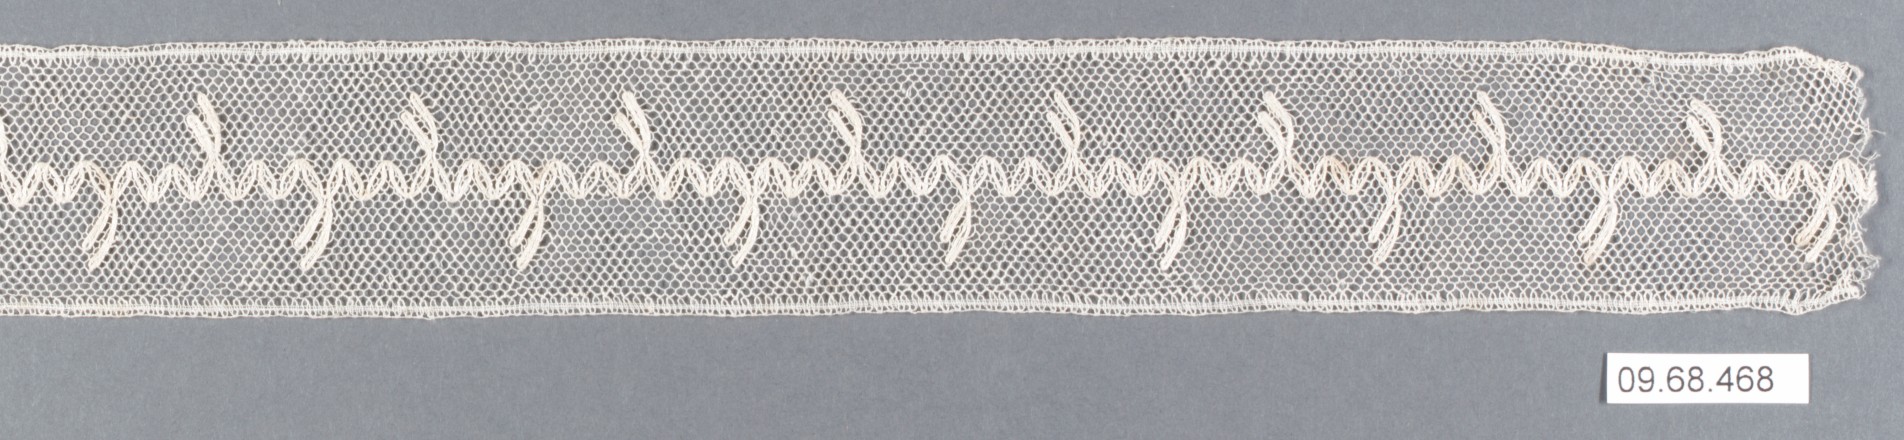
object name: fragment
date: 1801-1900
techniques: lace